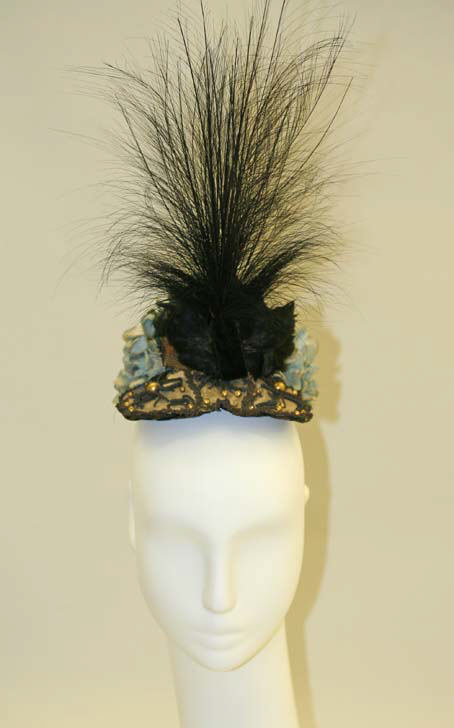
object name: hat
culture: american or european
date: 1890-1899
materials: leather